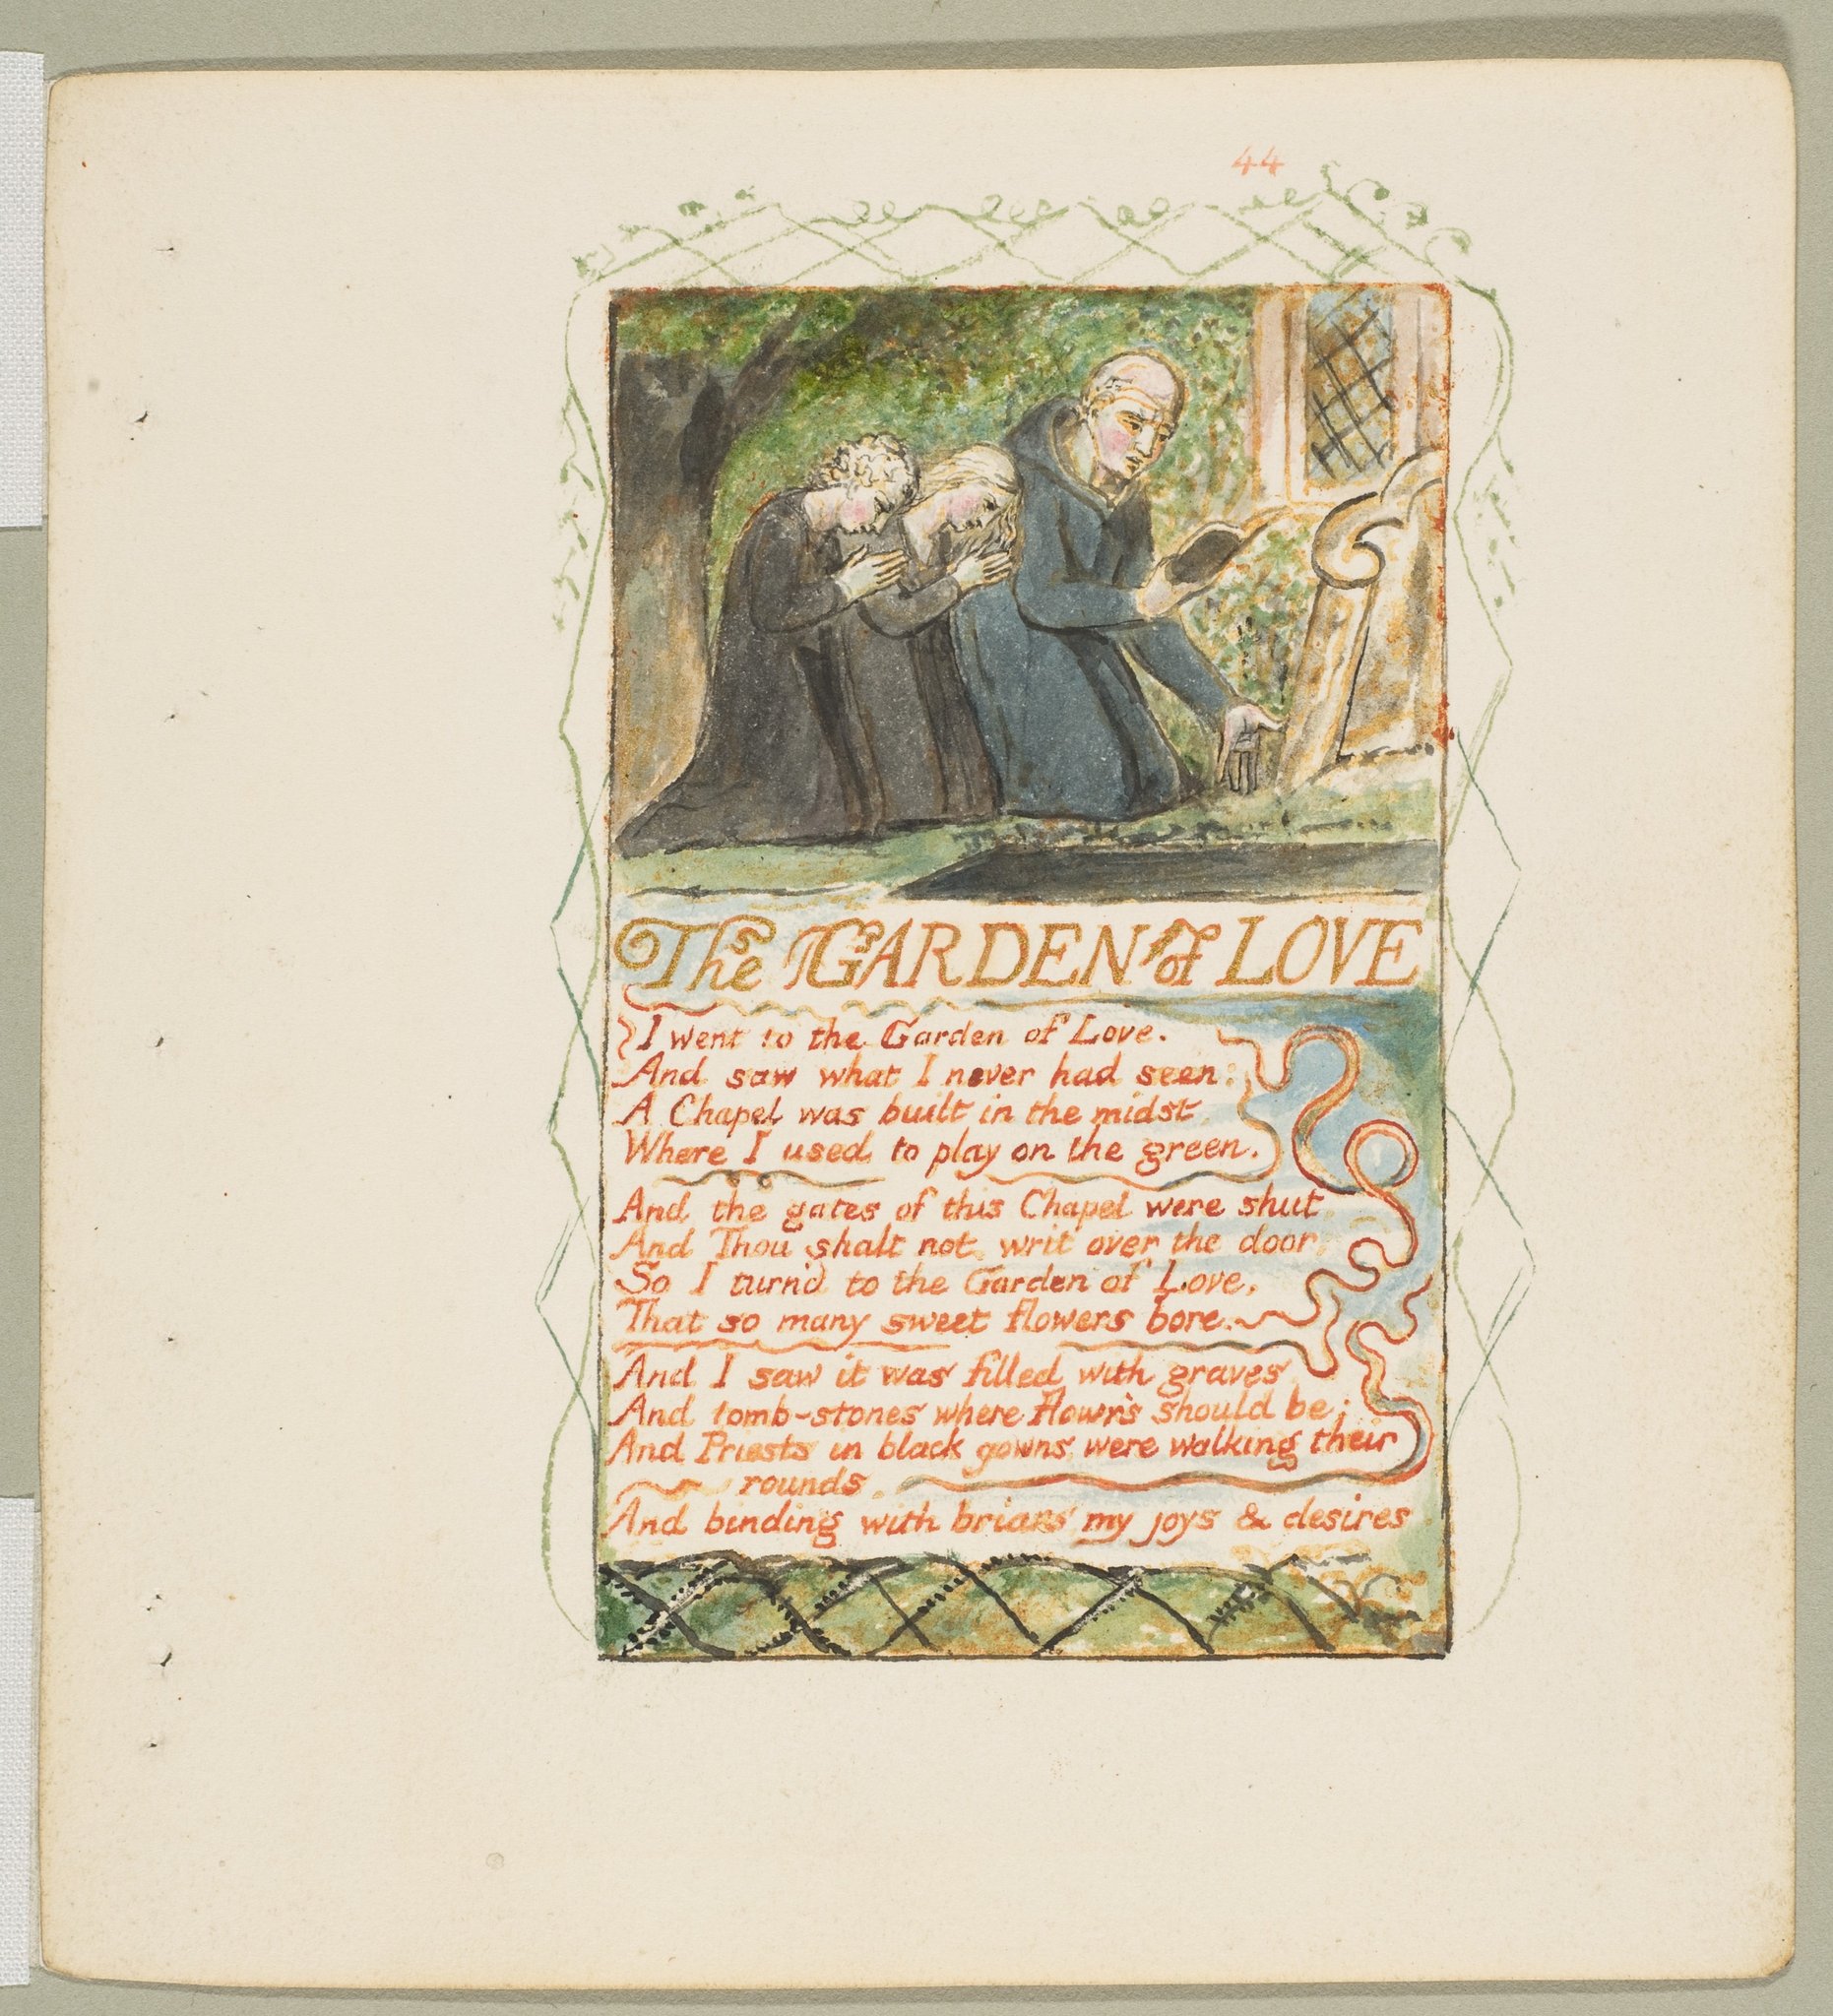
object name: print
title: Songs of Experience: The Garden of Love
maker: william blake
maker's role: artist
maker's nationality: british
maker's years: 1757-1827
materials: gold, ink, shell, watercolor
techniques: etching, hand coloring, printing, relief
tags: poetry,men,women,reading